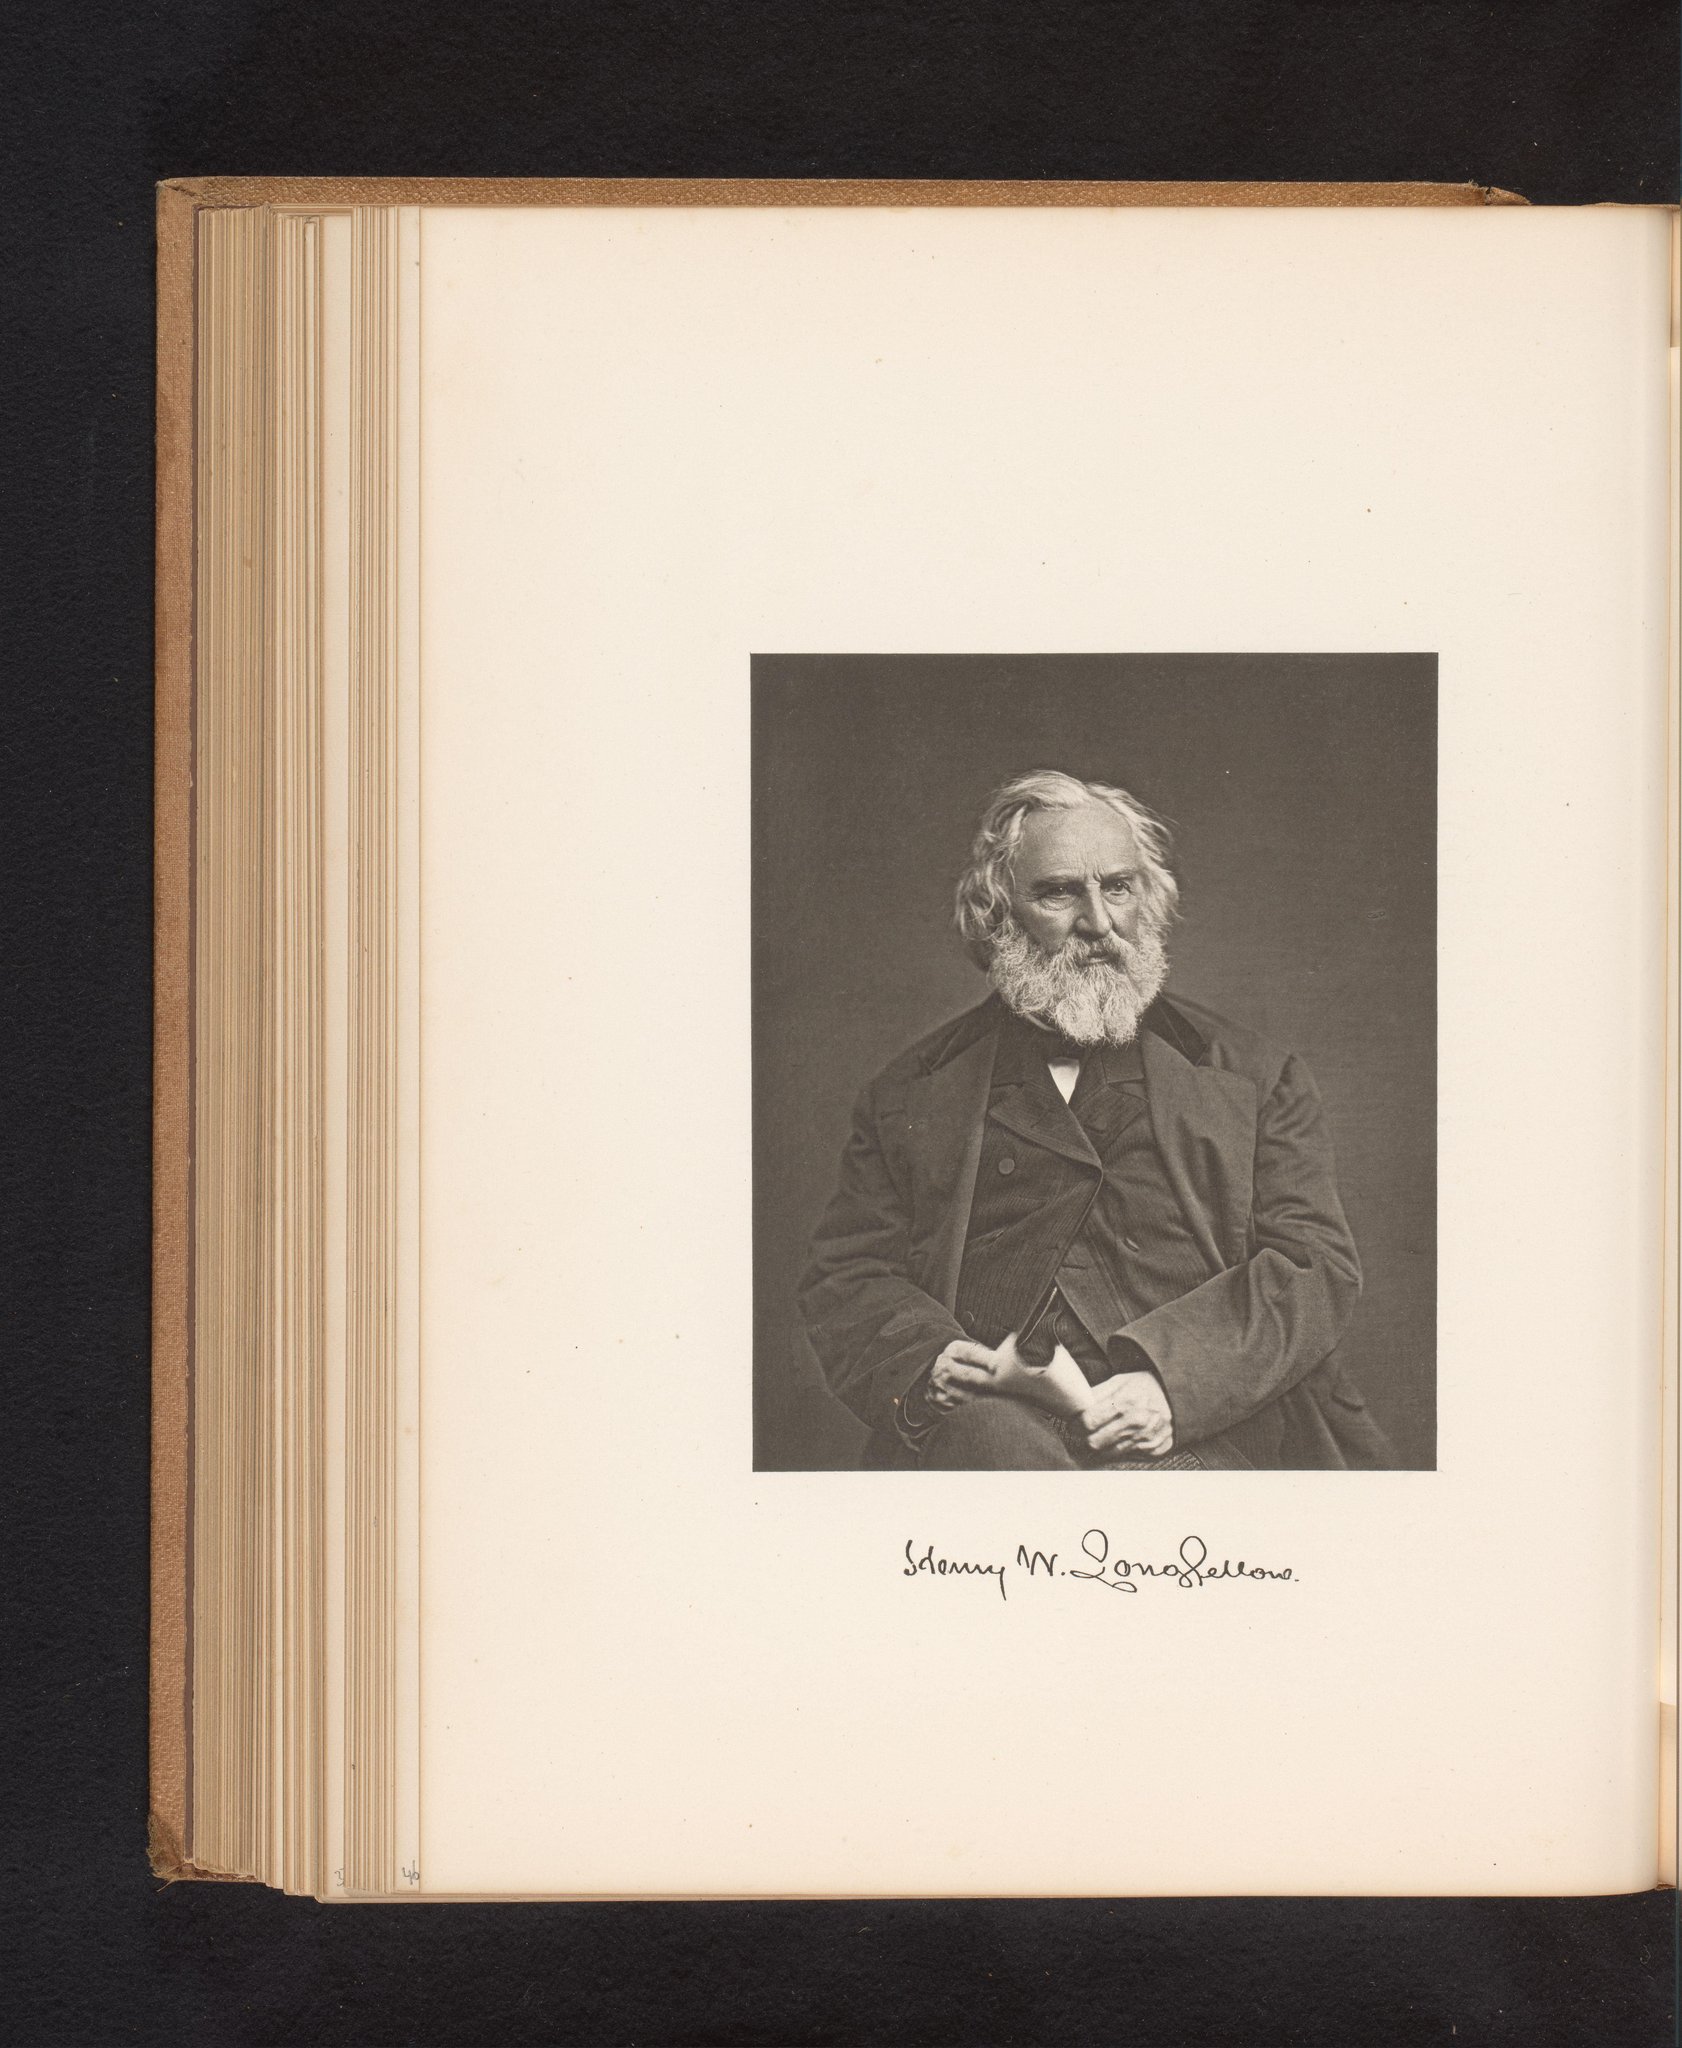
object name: page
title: Henry W. Longfellow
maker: Anonymous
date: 1870-1875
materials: paper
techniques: photograph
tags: henry wadsworth longfellow, historical persons, writer, poet, author